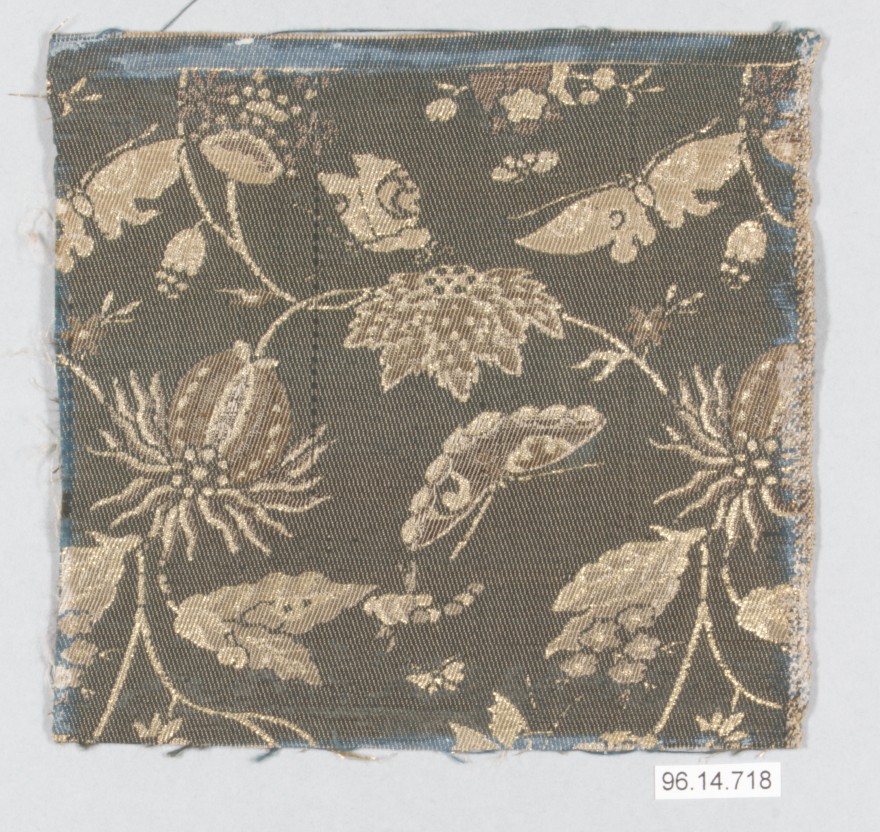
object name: piece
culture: japanese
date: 1801-1900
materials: metal thread, silk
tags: insects,flowers